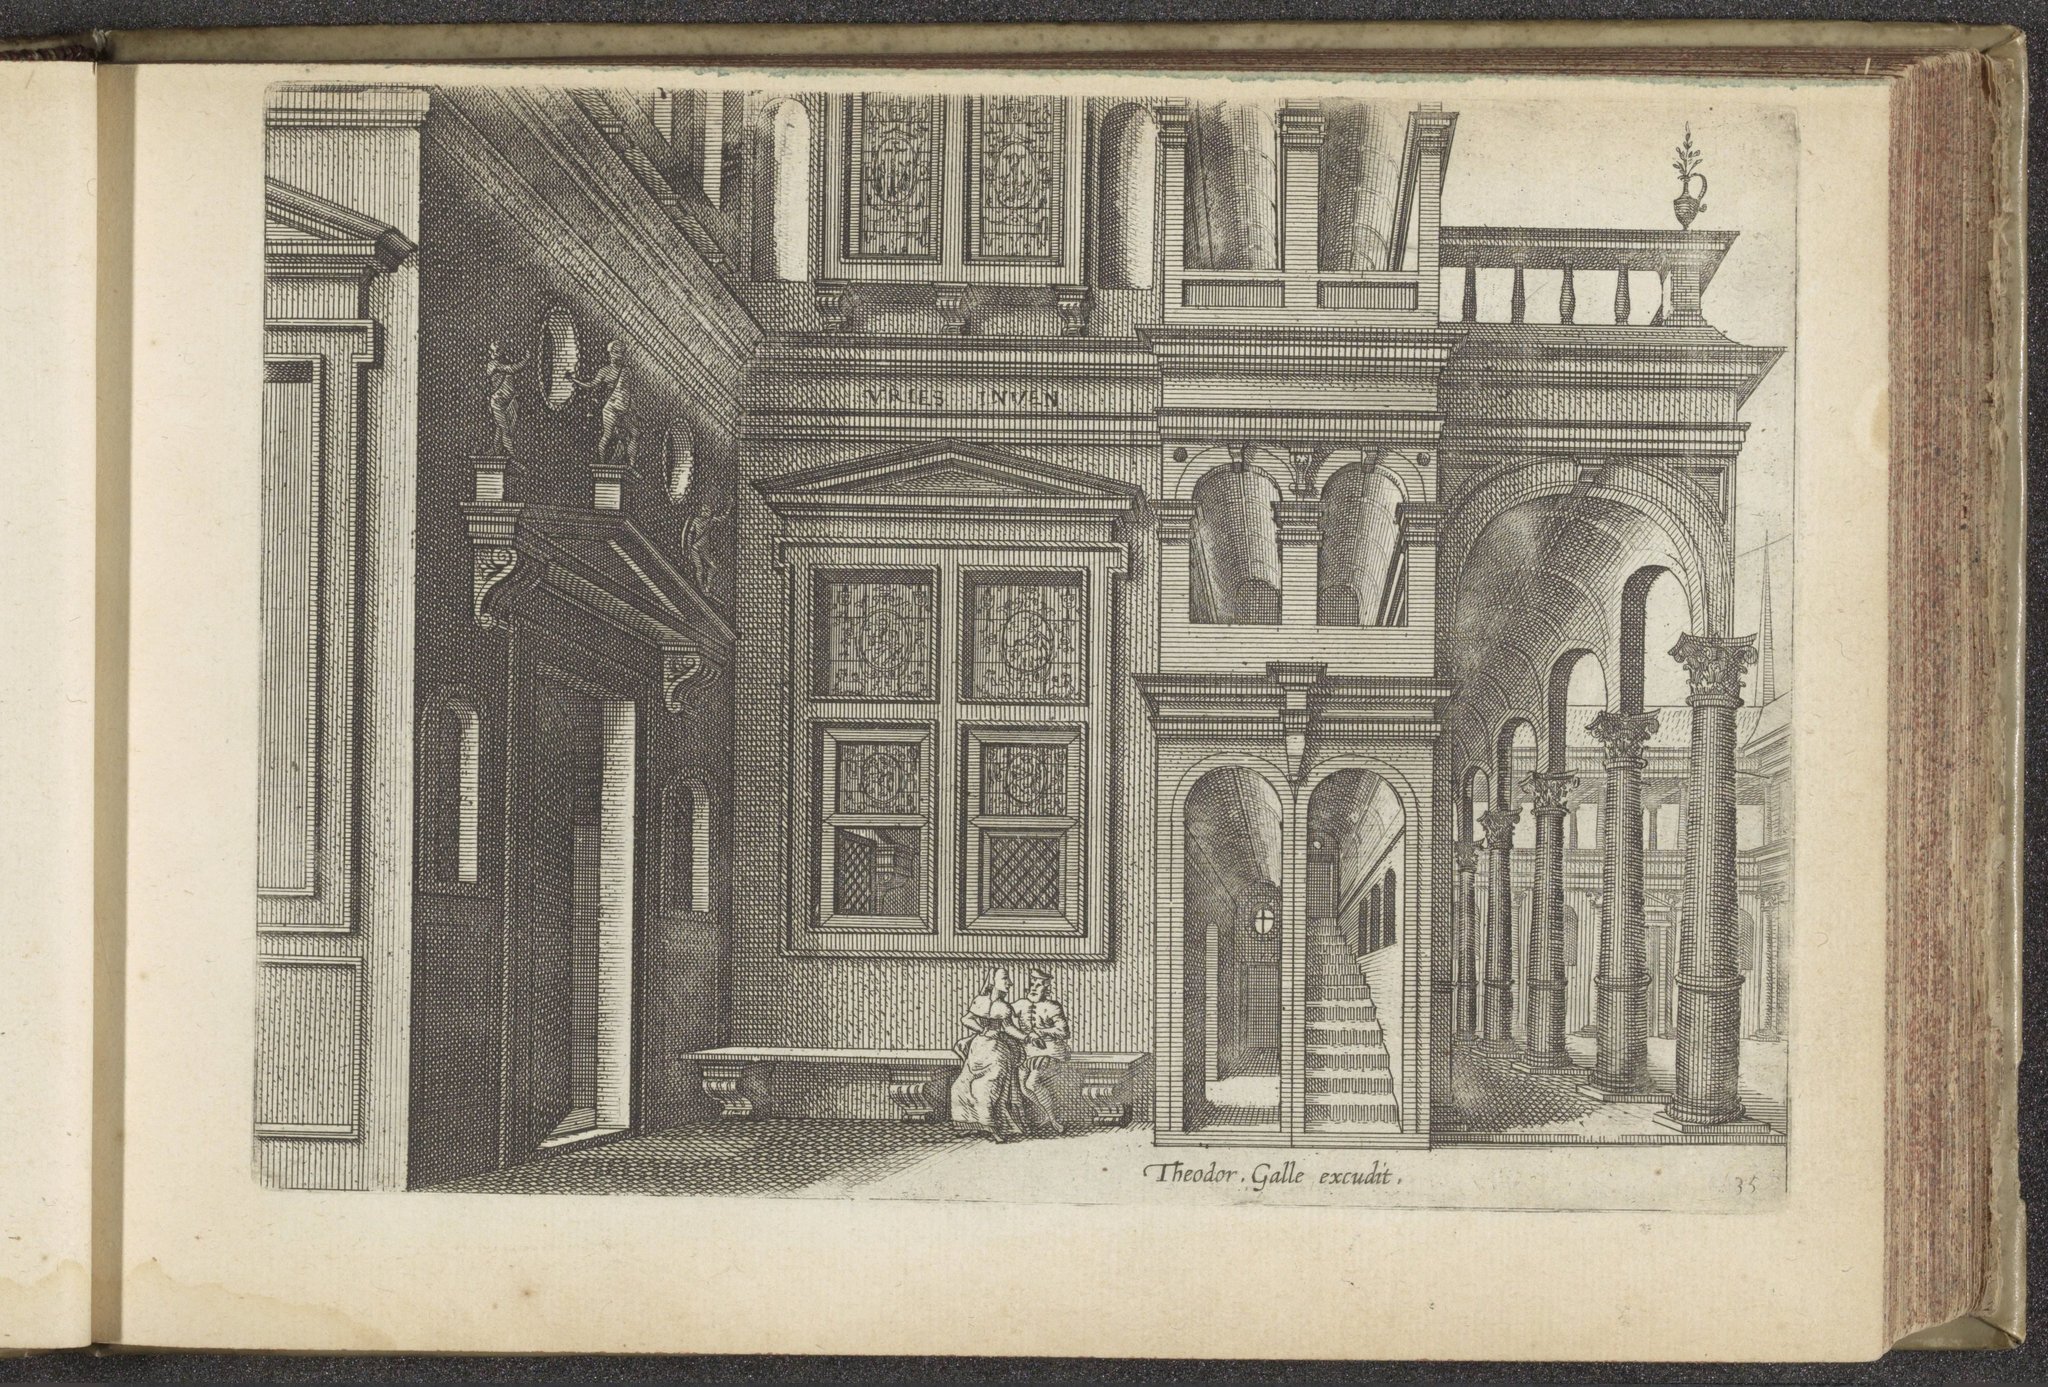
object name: album leaf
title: Variae Architecturae formae (...)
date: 1562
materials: paper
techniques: etching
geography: antwerp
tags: bench, architectural representations in general, courtyard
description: Gezicht op de binnenplaats van een huis met een paar op een bank. Deze prent maakt deel uit van een album.